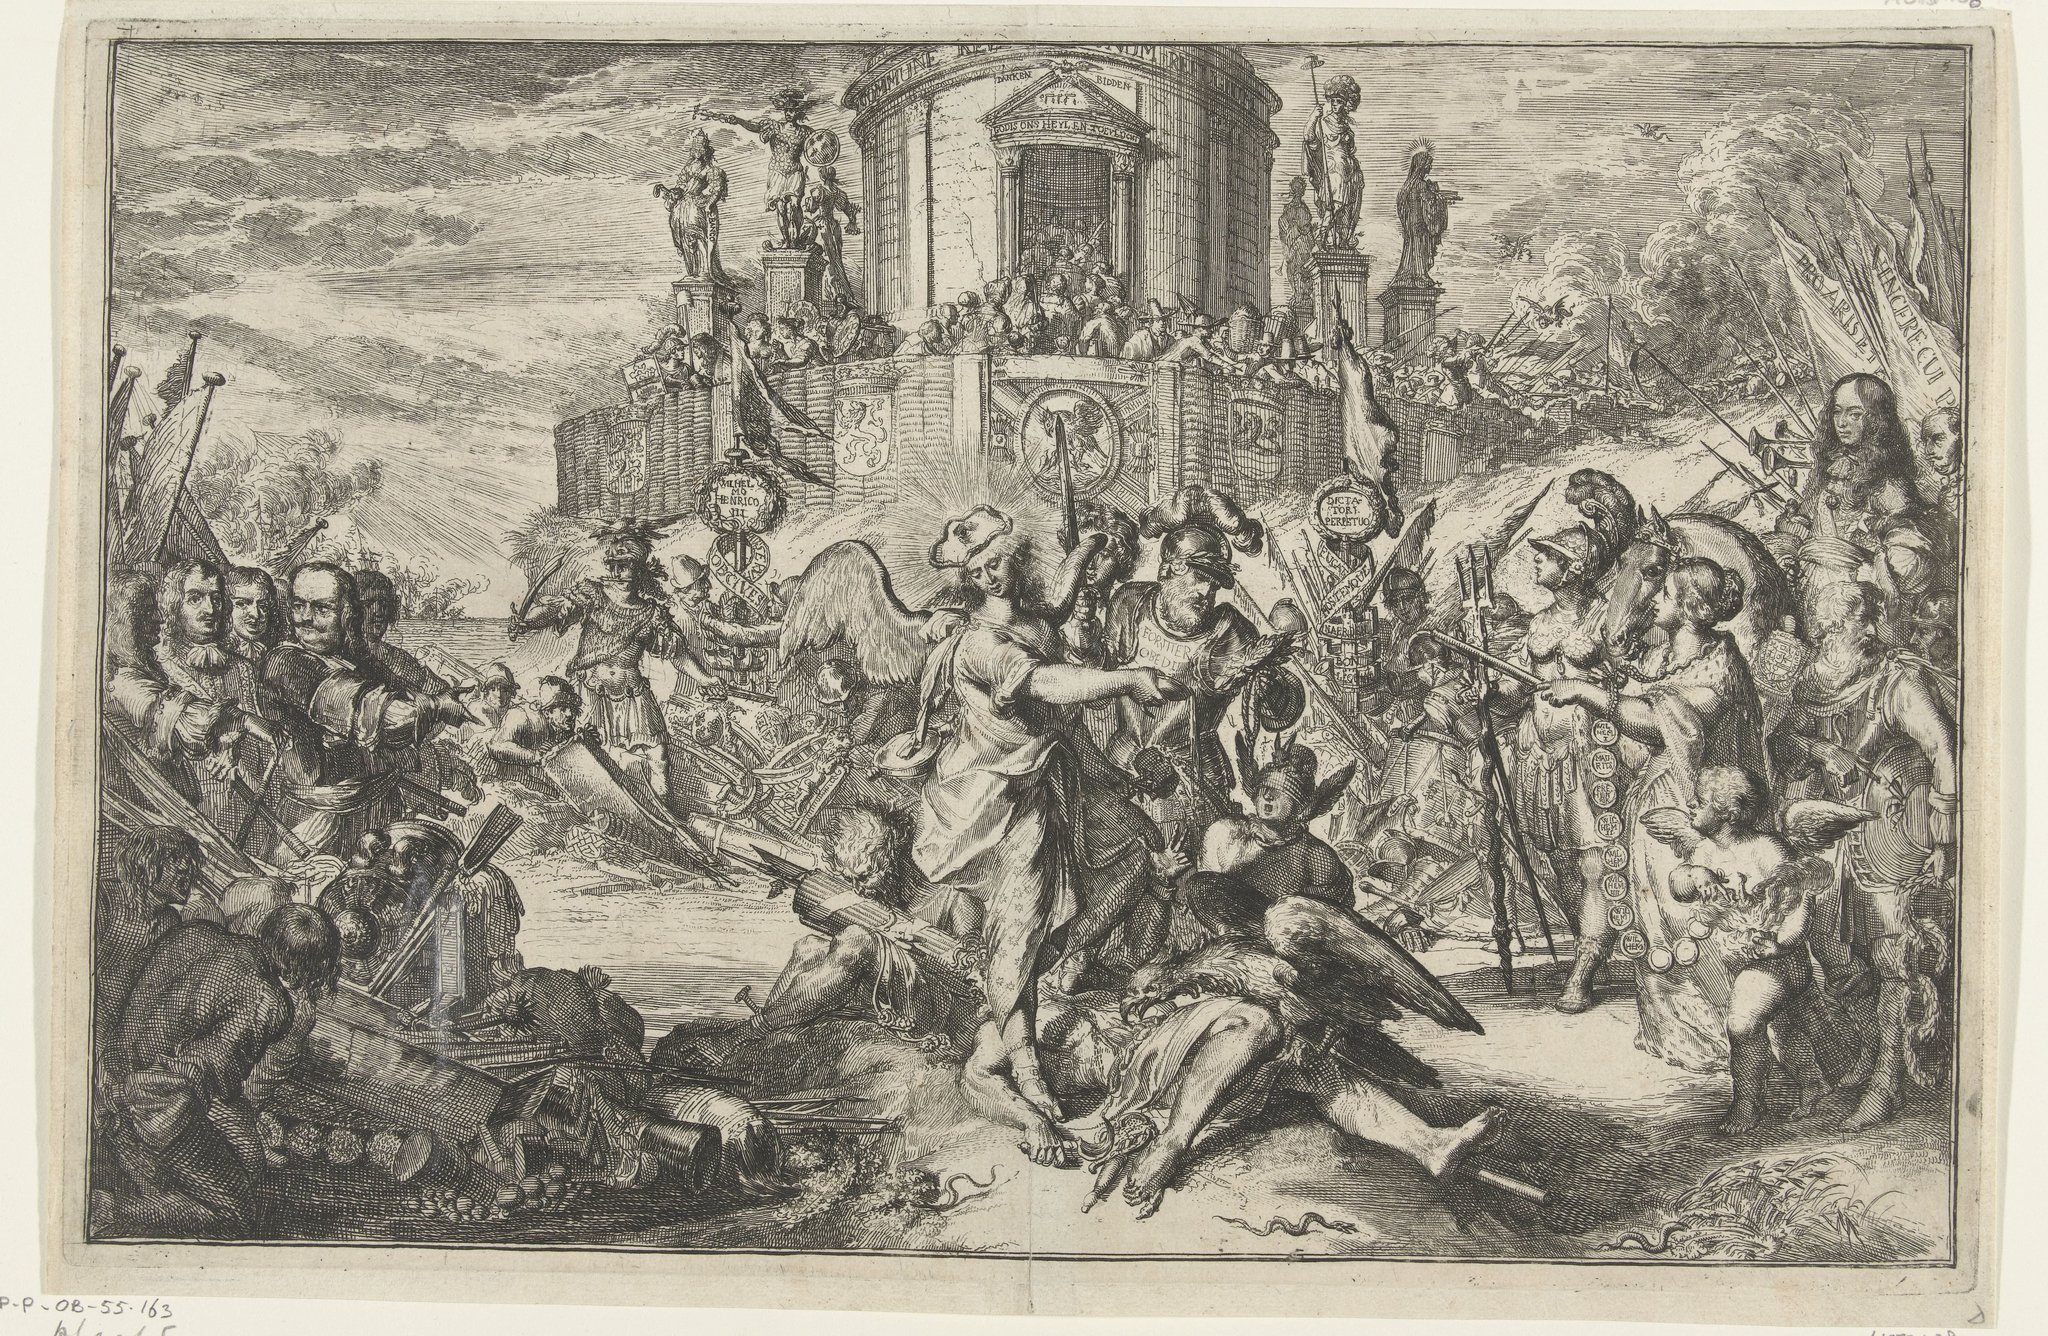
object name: propagandaprent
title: Overwinningen met de komst van Willem III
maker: romeyn de hooghe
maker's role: draughtsman, goldsmith, painter, print maker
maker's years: 1645-1708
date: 1674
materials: paper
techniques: etching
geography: amsterdam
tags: flushing, michiel adriaenszoon de ruyter, amsterdam, cornelis tromp, the hague, william iii (prince of orange and king of england, scotland, and ireland), netherlands, rampjaar (disaster year)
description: Overwinningen met de komst van Willem III. De eenheid van de Unie wordt hersteld, het volk stroomt de tempel binnen. Rechts Willem III voorafgegaan door personificaties van zijn ambt als stadhouder en kapitein-generaal. Links de helden die de Hollandse overwinningen op de vijand bevochten: De Ruyter, Tromp en Van Nes. Centraal wordt de overwinning allegorisch verbeeld.